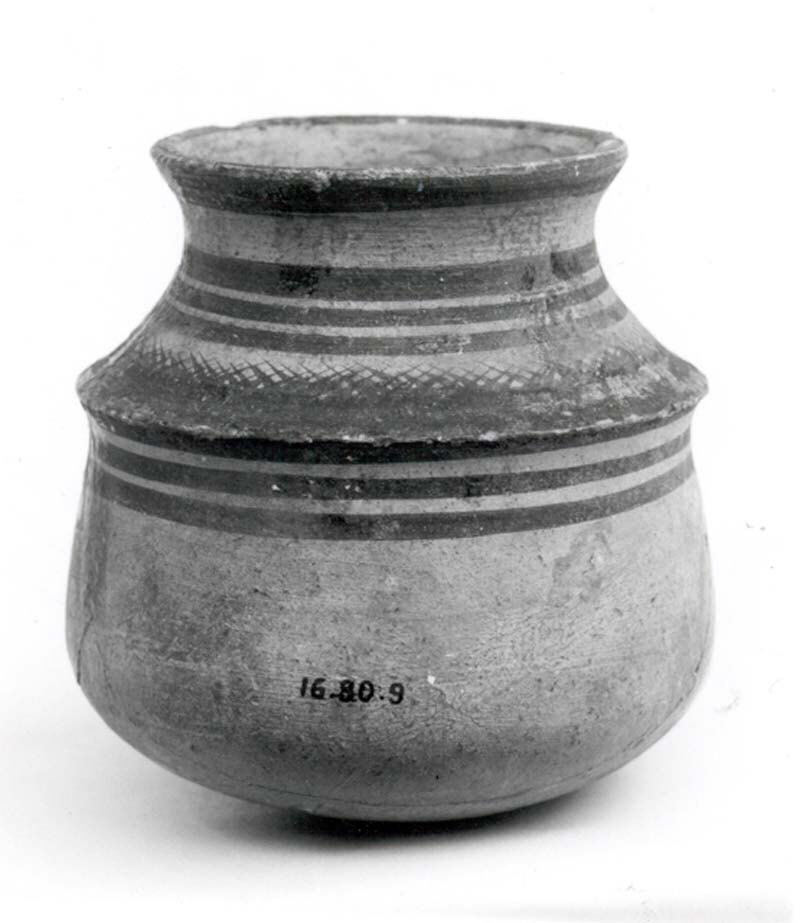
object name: jar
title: Jar with painted decoration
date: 2000-1600 BCE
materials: ceramic, paint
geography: western iran